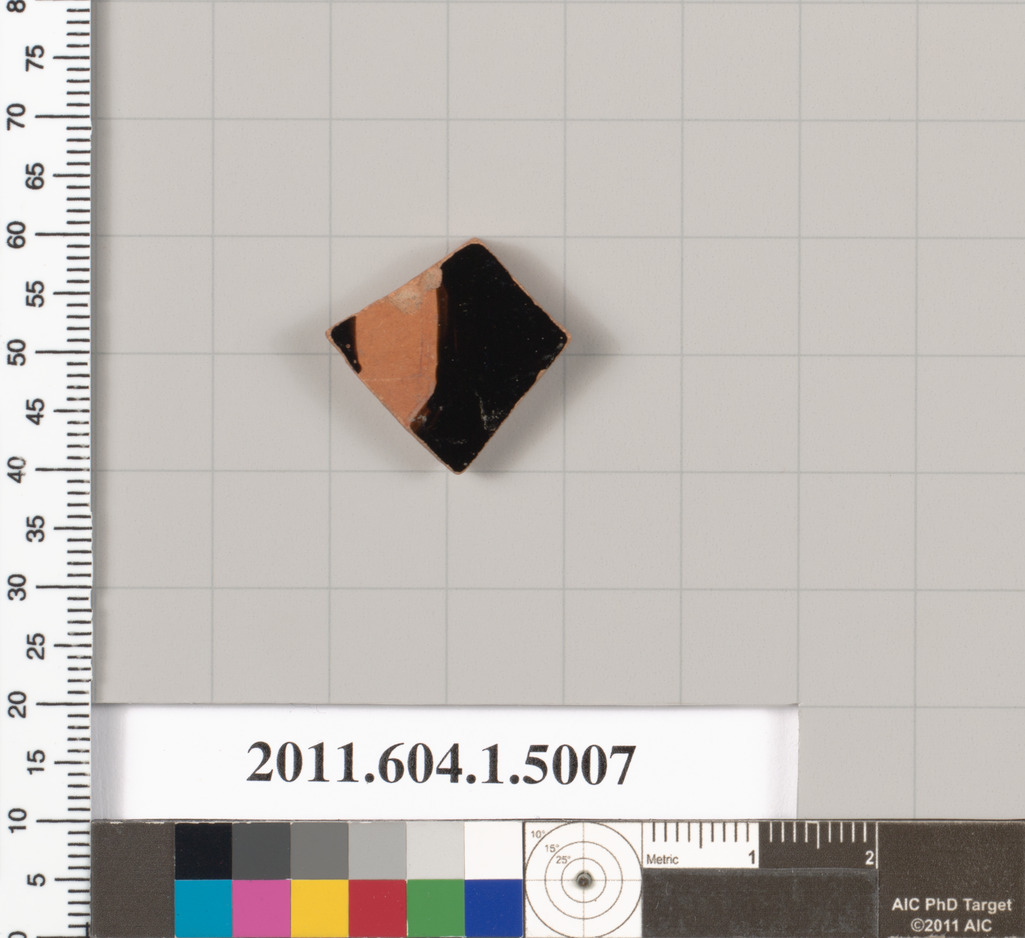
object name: kylix fragment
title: Terracotta fragment of a kylix (drinking cup)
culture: greek, attic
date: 500-480 BCE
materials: terracotta